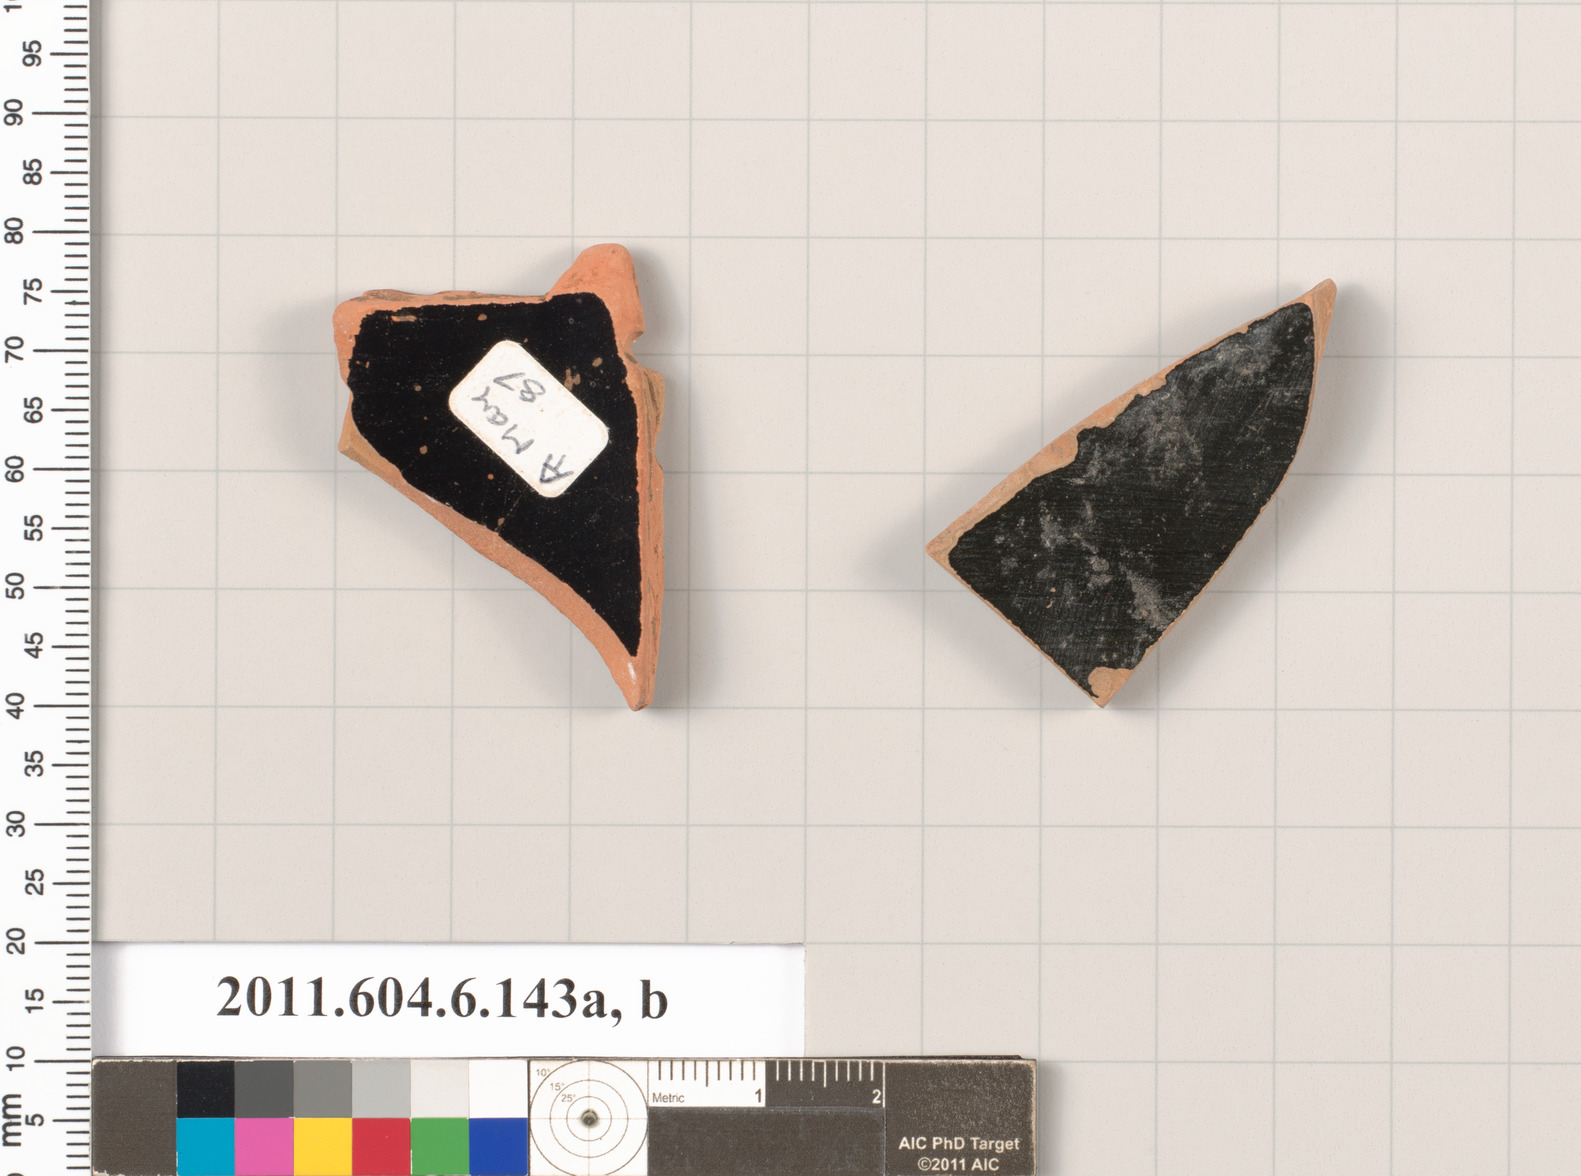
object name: undetermined open shape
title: Terracotta fragments of open shapes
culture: greek, attic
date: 600-401 BCE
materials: terracotta